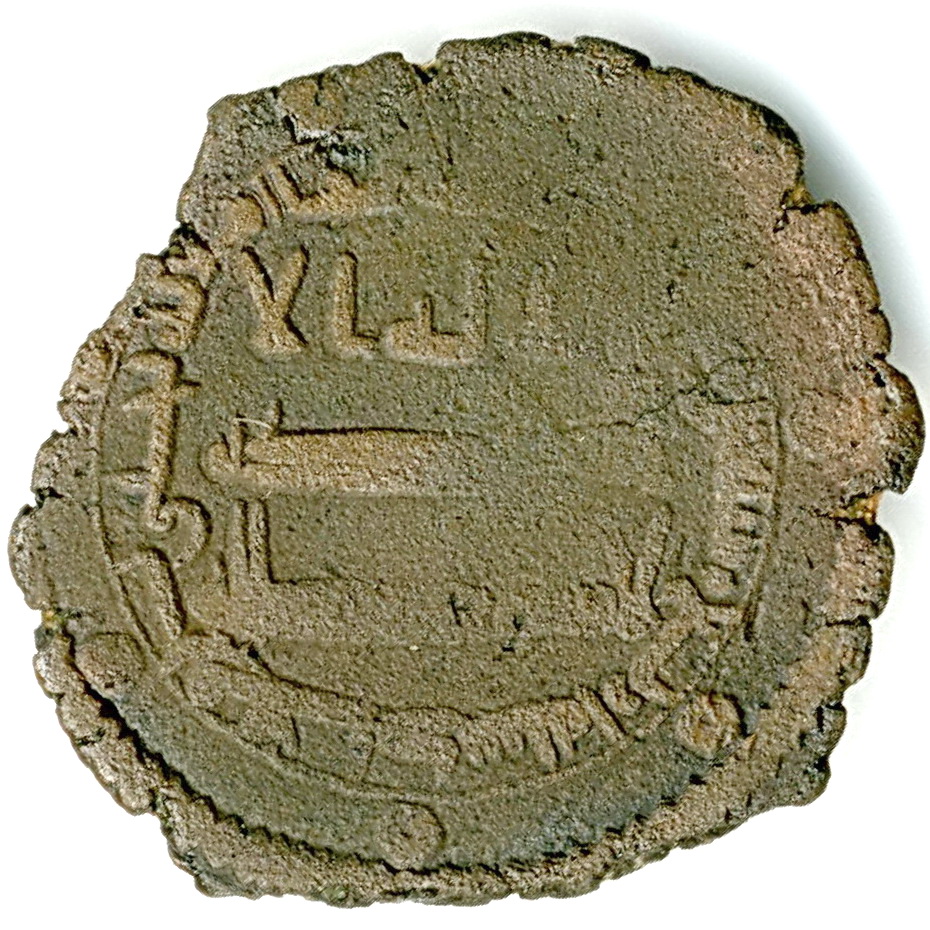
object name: coin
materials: copper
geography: iran